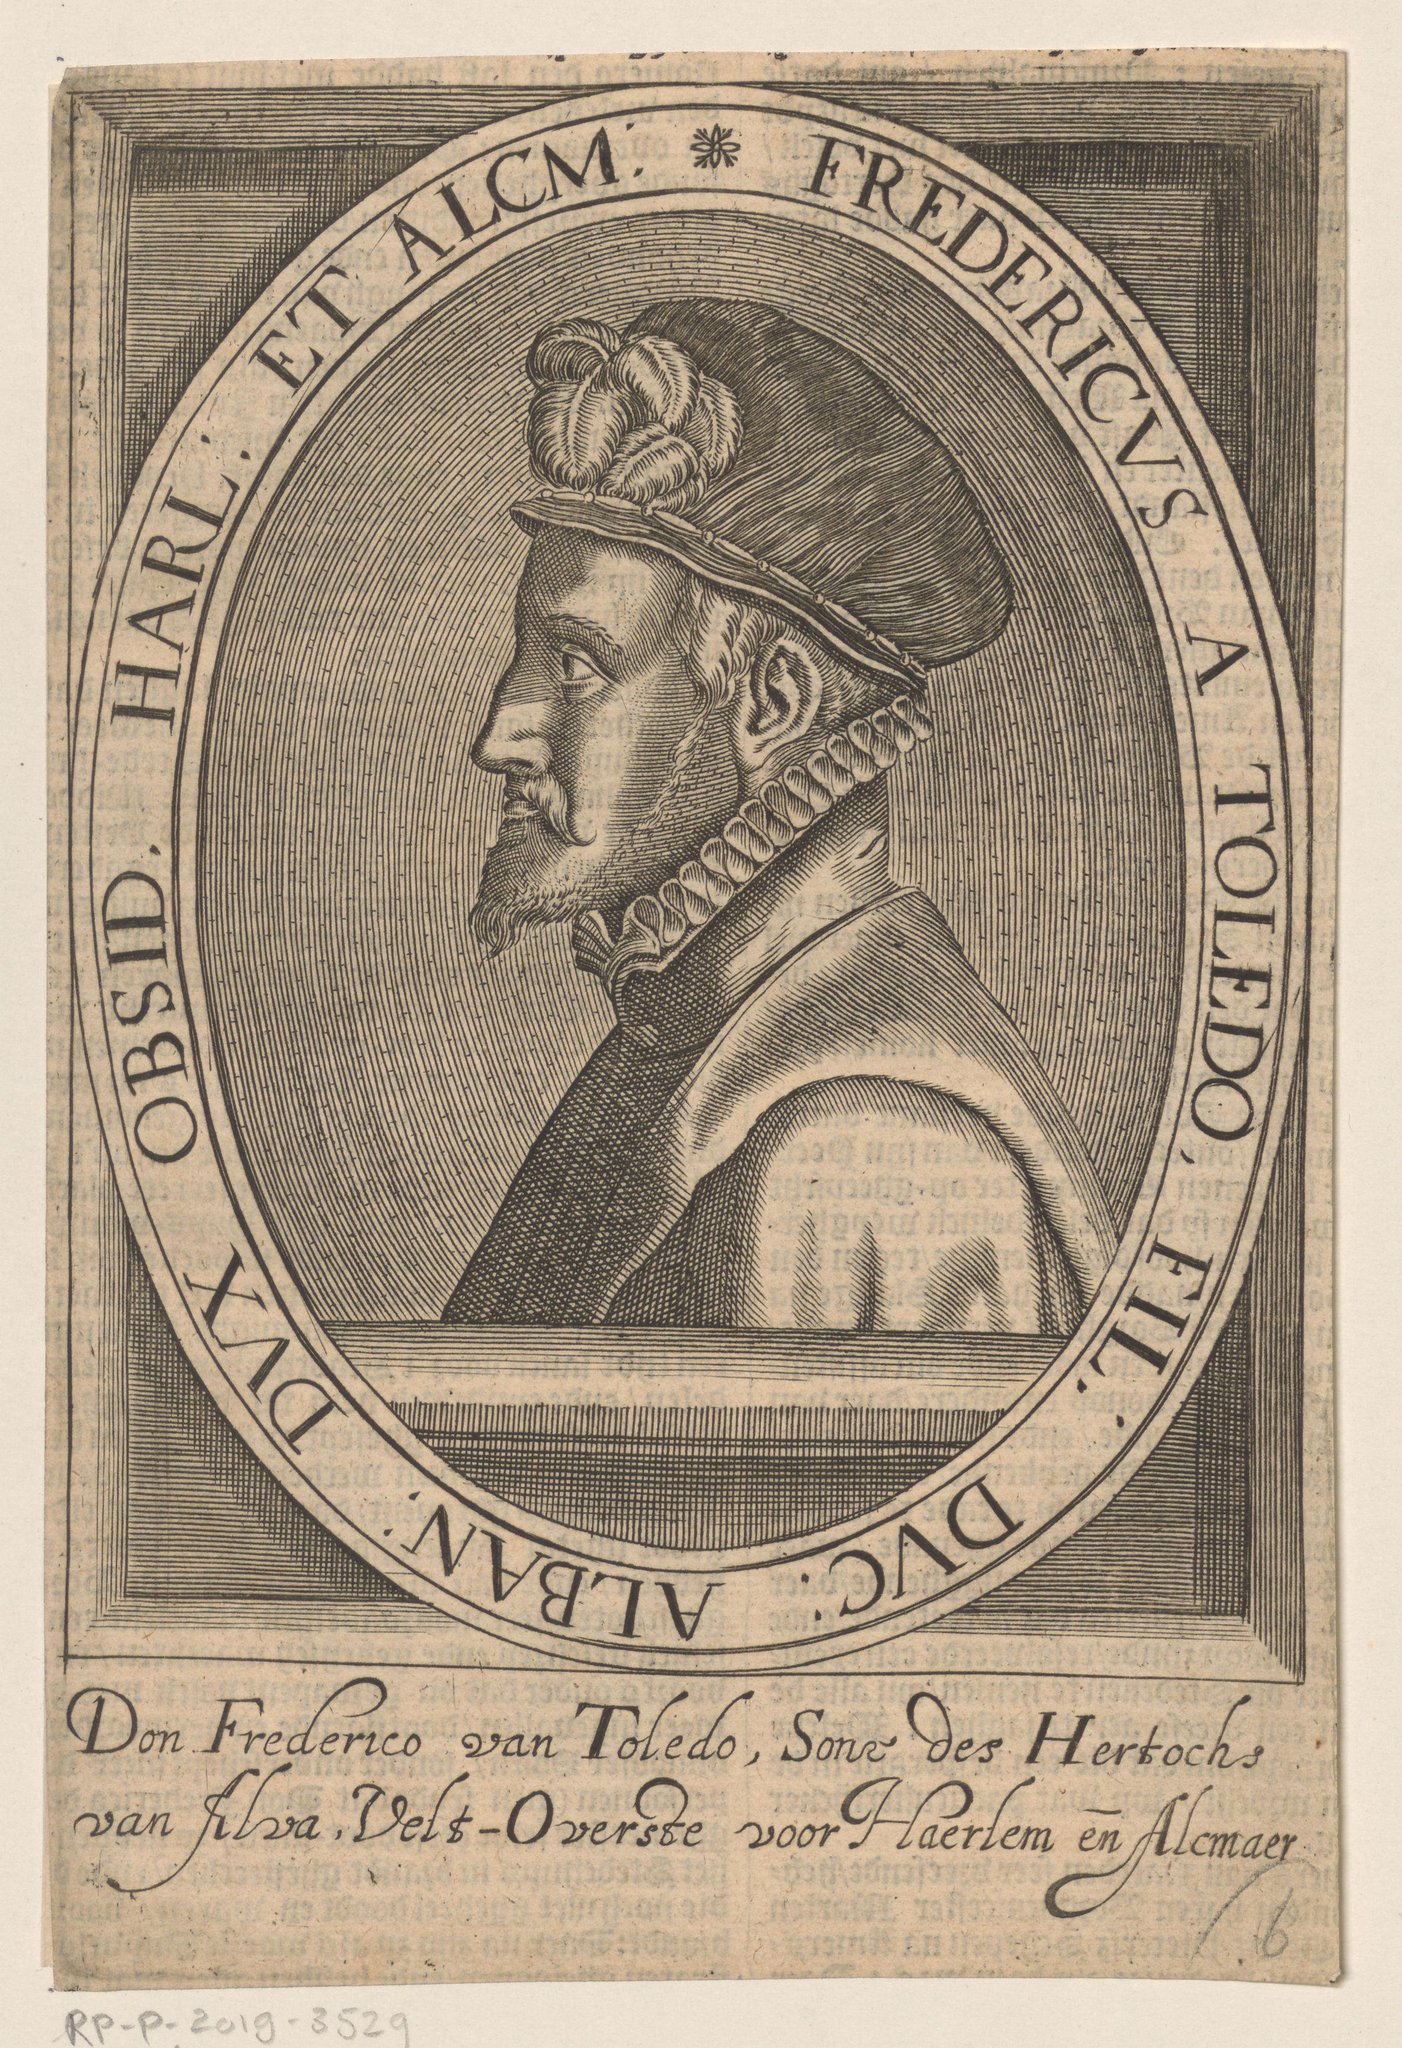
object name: book illustration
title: Portret van Fadrique Álvarez de Toledo, hertog van Alva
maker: Anonymous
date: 1600-1699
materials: paper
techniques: engraving, etching, letterpress printing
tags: historical persons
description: Prent uit een van de edities van: Meteren, Emanuel van. Historie der Nederlandscher ende haerder na-buren oorlogen ende geschiedenissen (...).